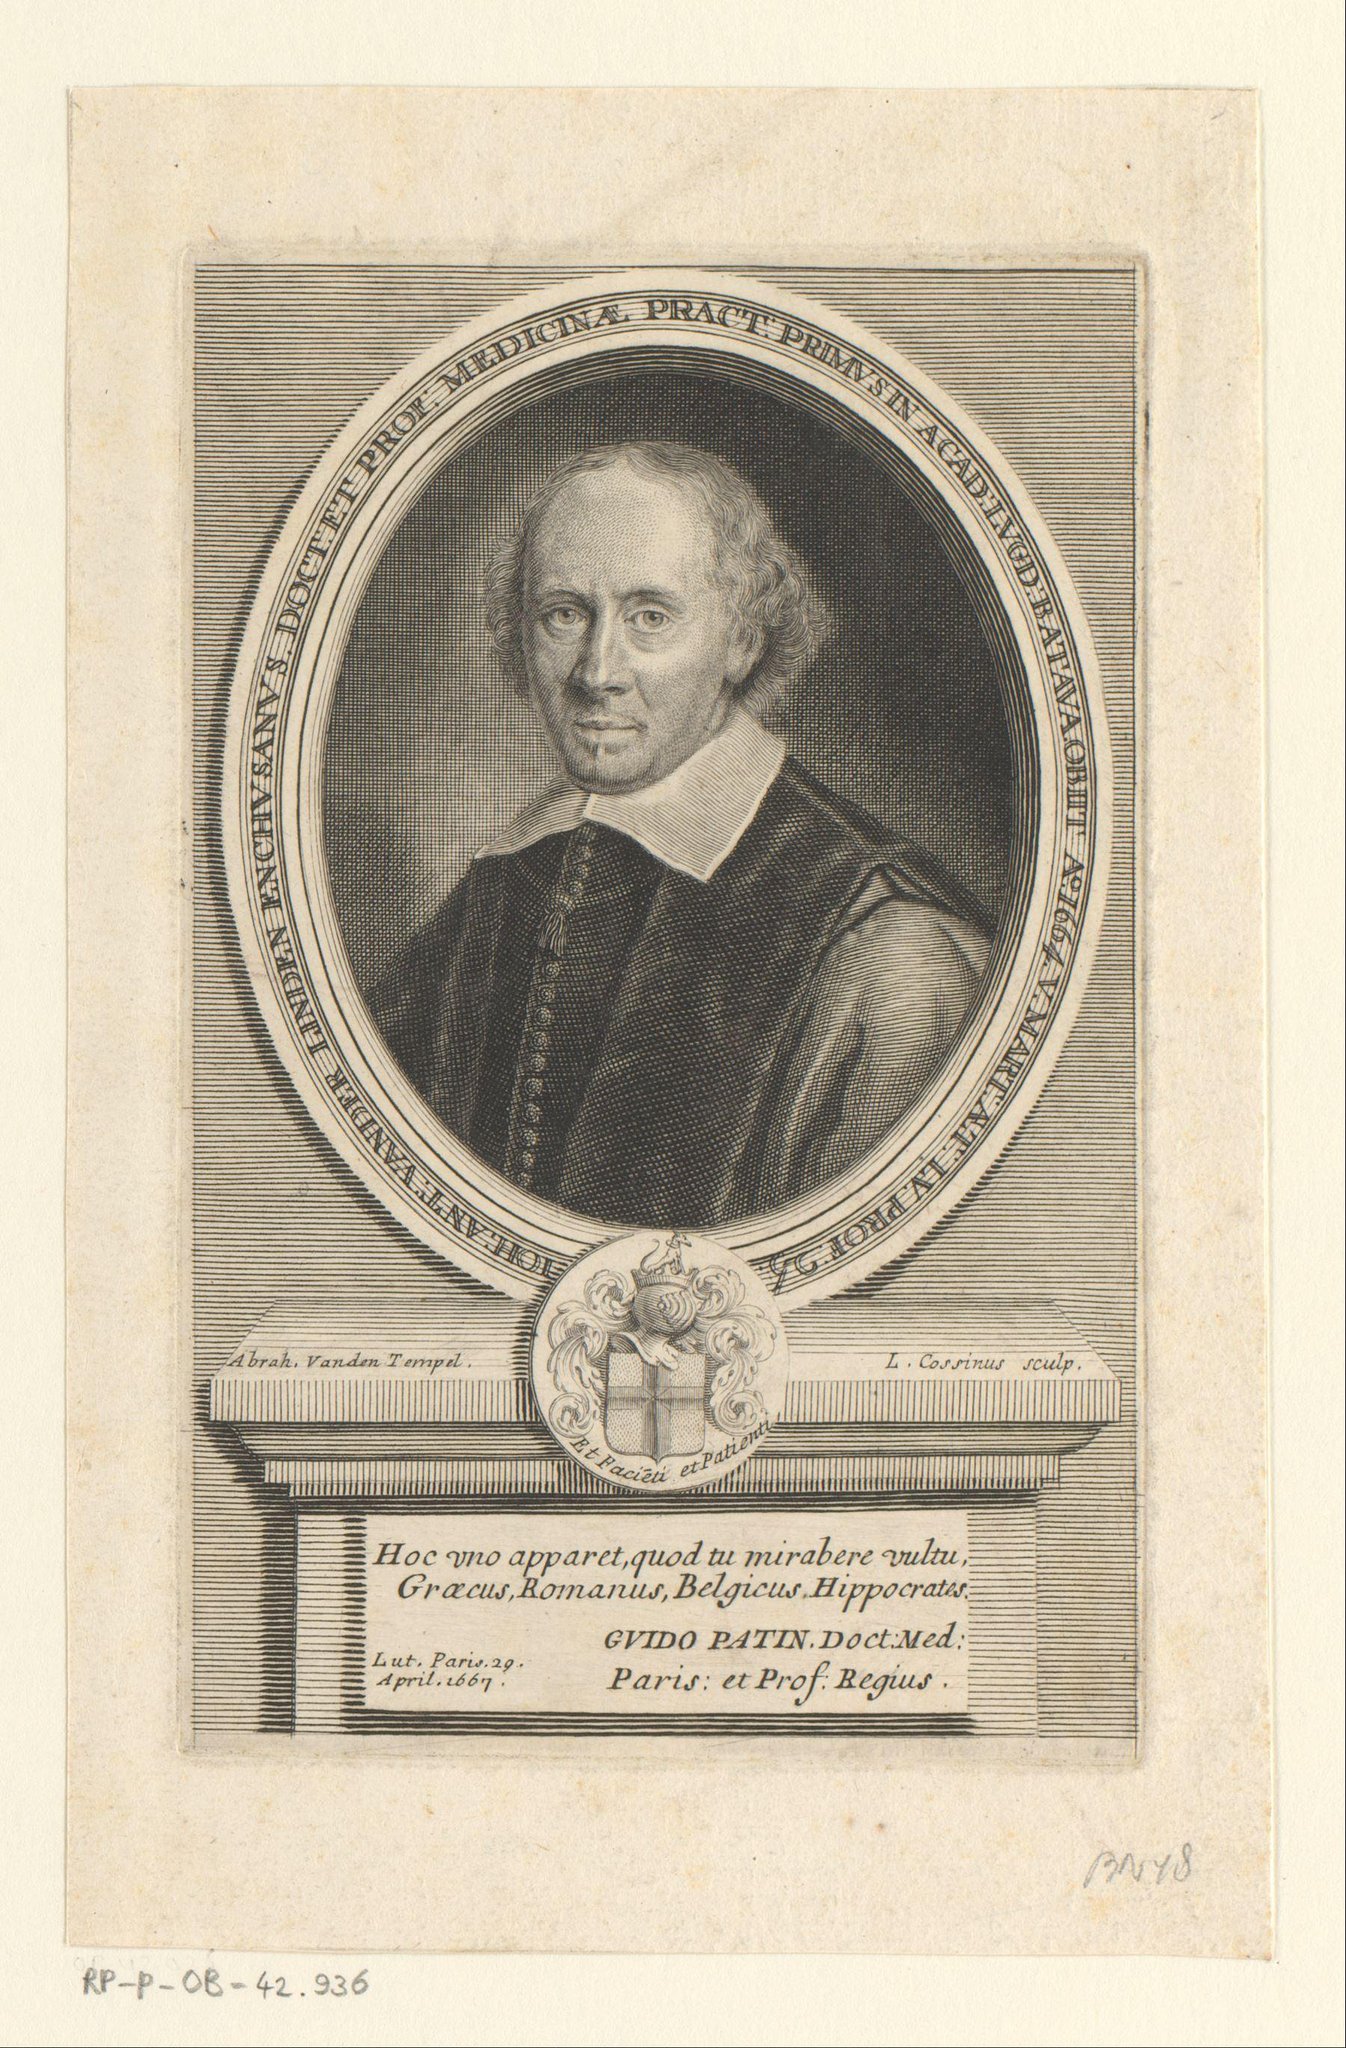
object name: print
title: Portret van Jan Antonides van der Linden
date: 1667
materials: paper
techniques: engraving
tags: enkhuizen, leiden, jan antonides van der linden, historical persons, armorial bearing, heraldry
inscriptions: collector's mark: Lugt 2228